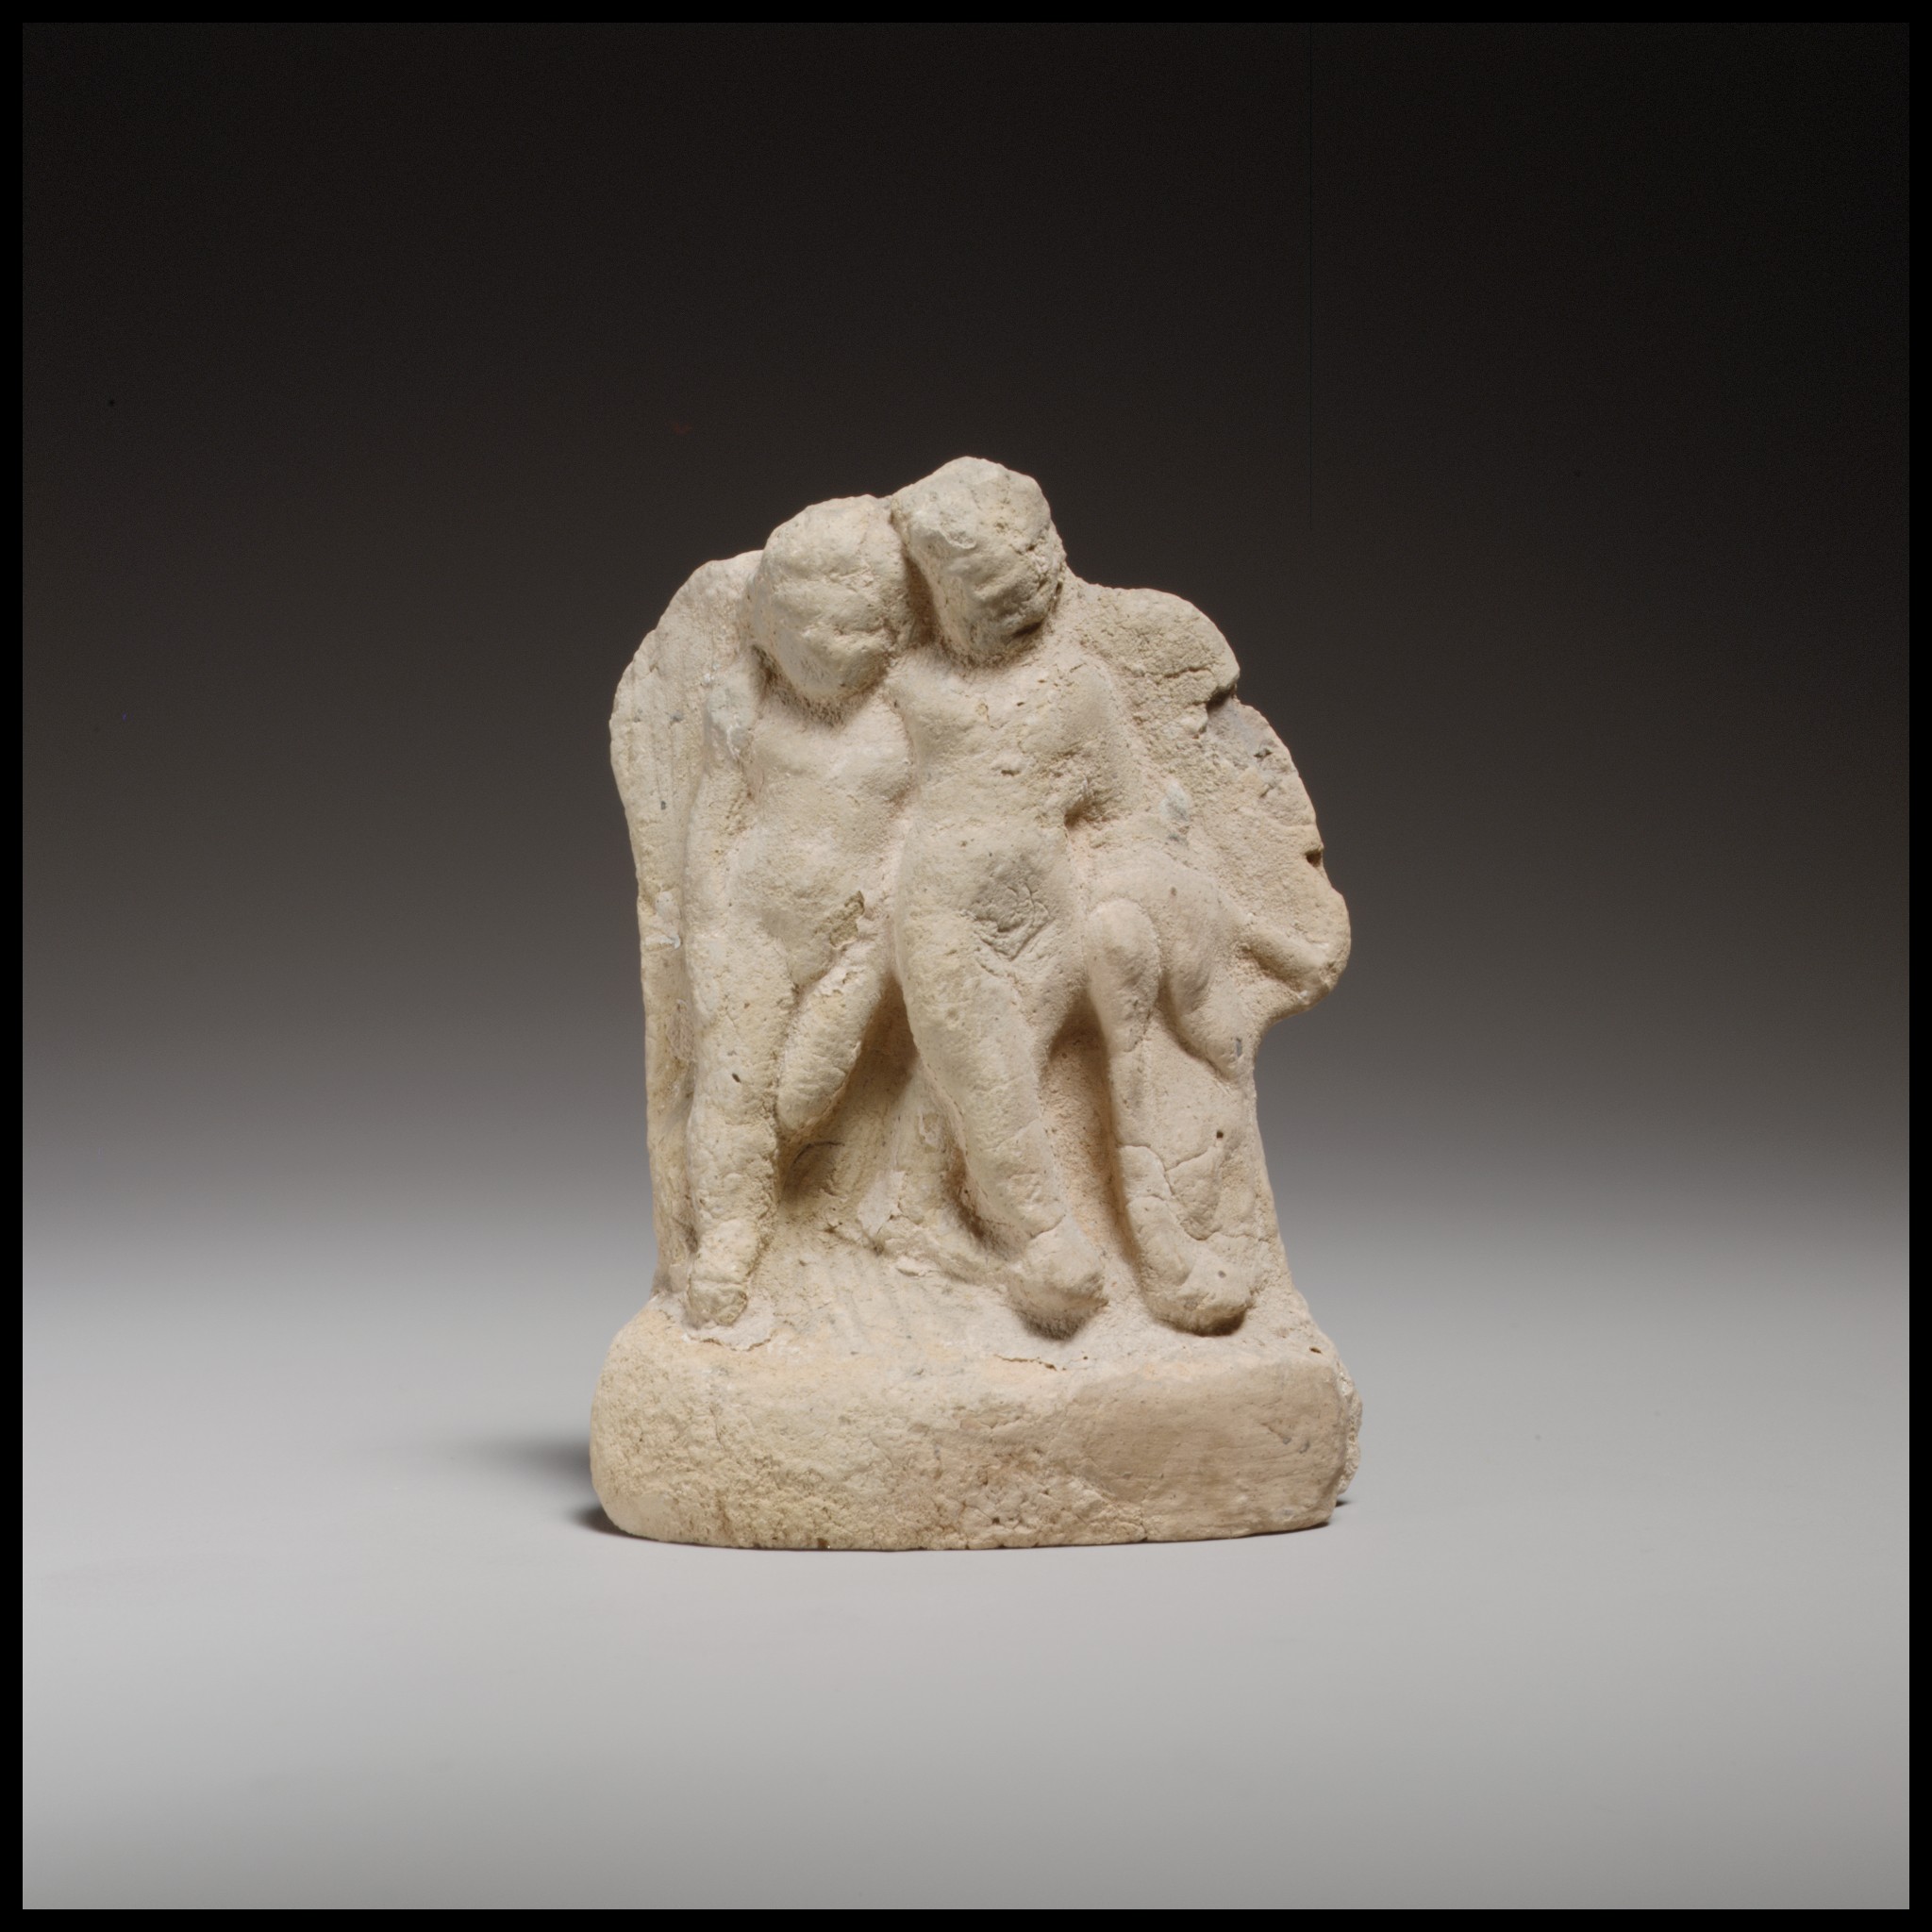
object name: relief of eros and psyche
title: Relief with two nude girls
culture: cypriot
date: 300-201 BCE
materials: terracotta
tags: female nudes